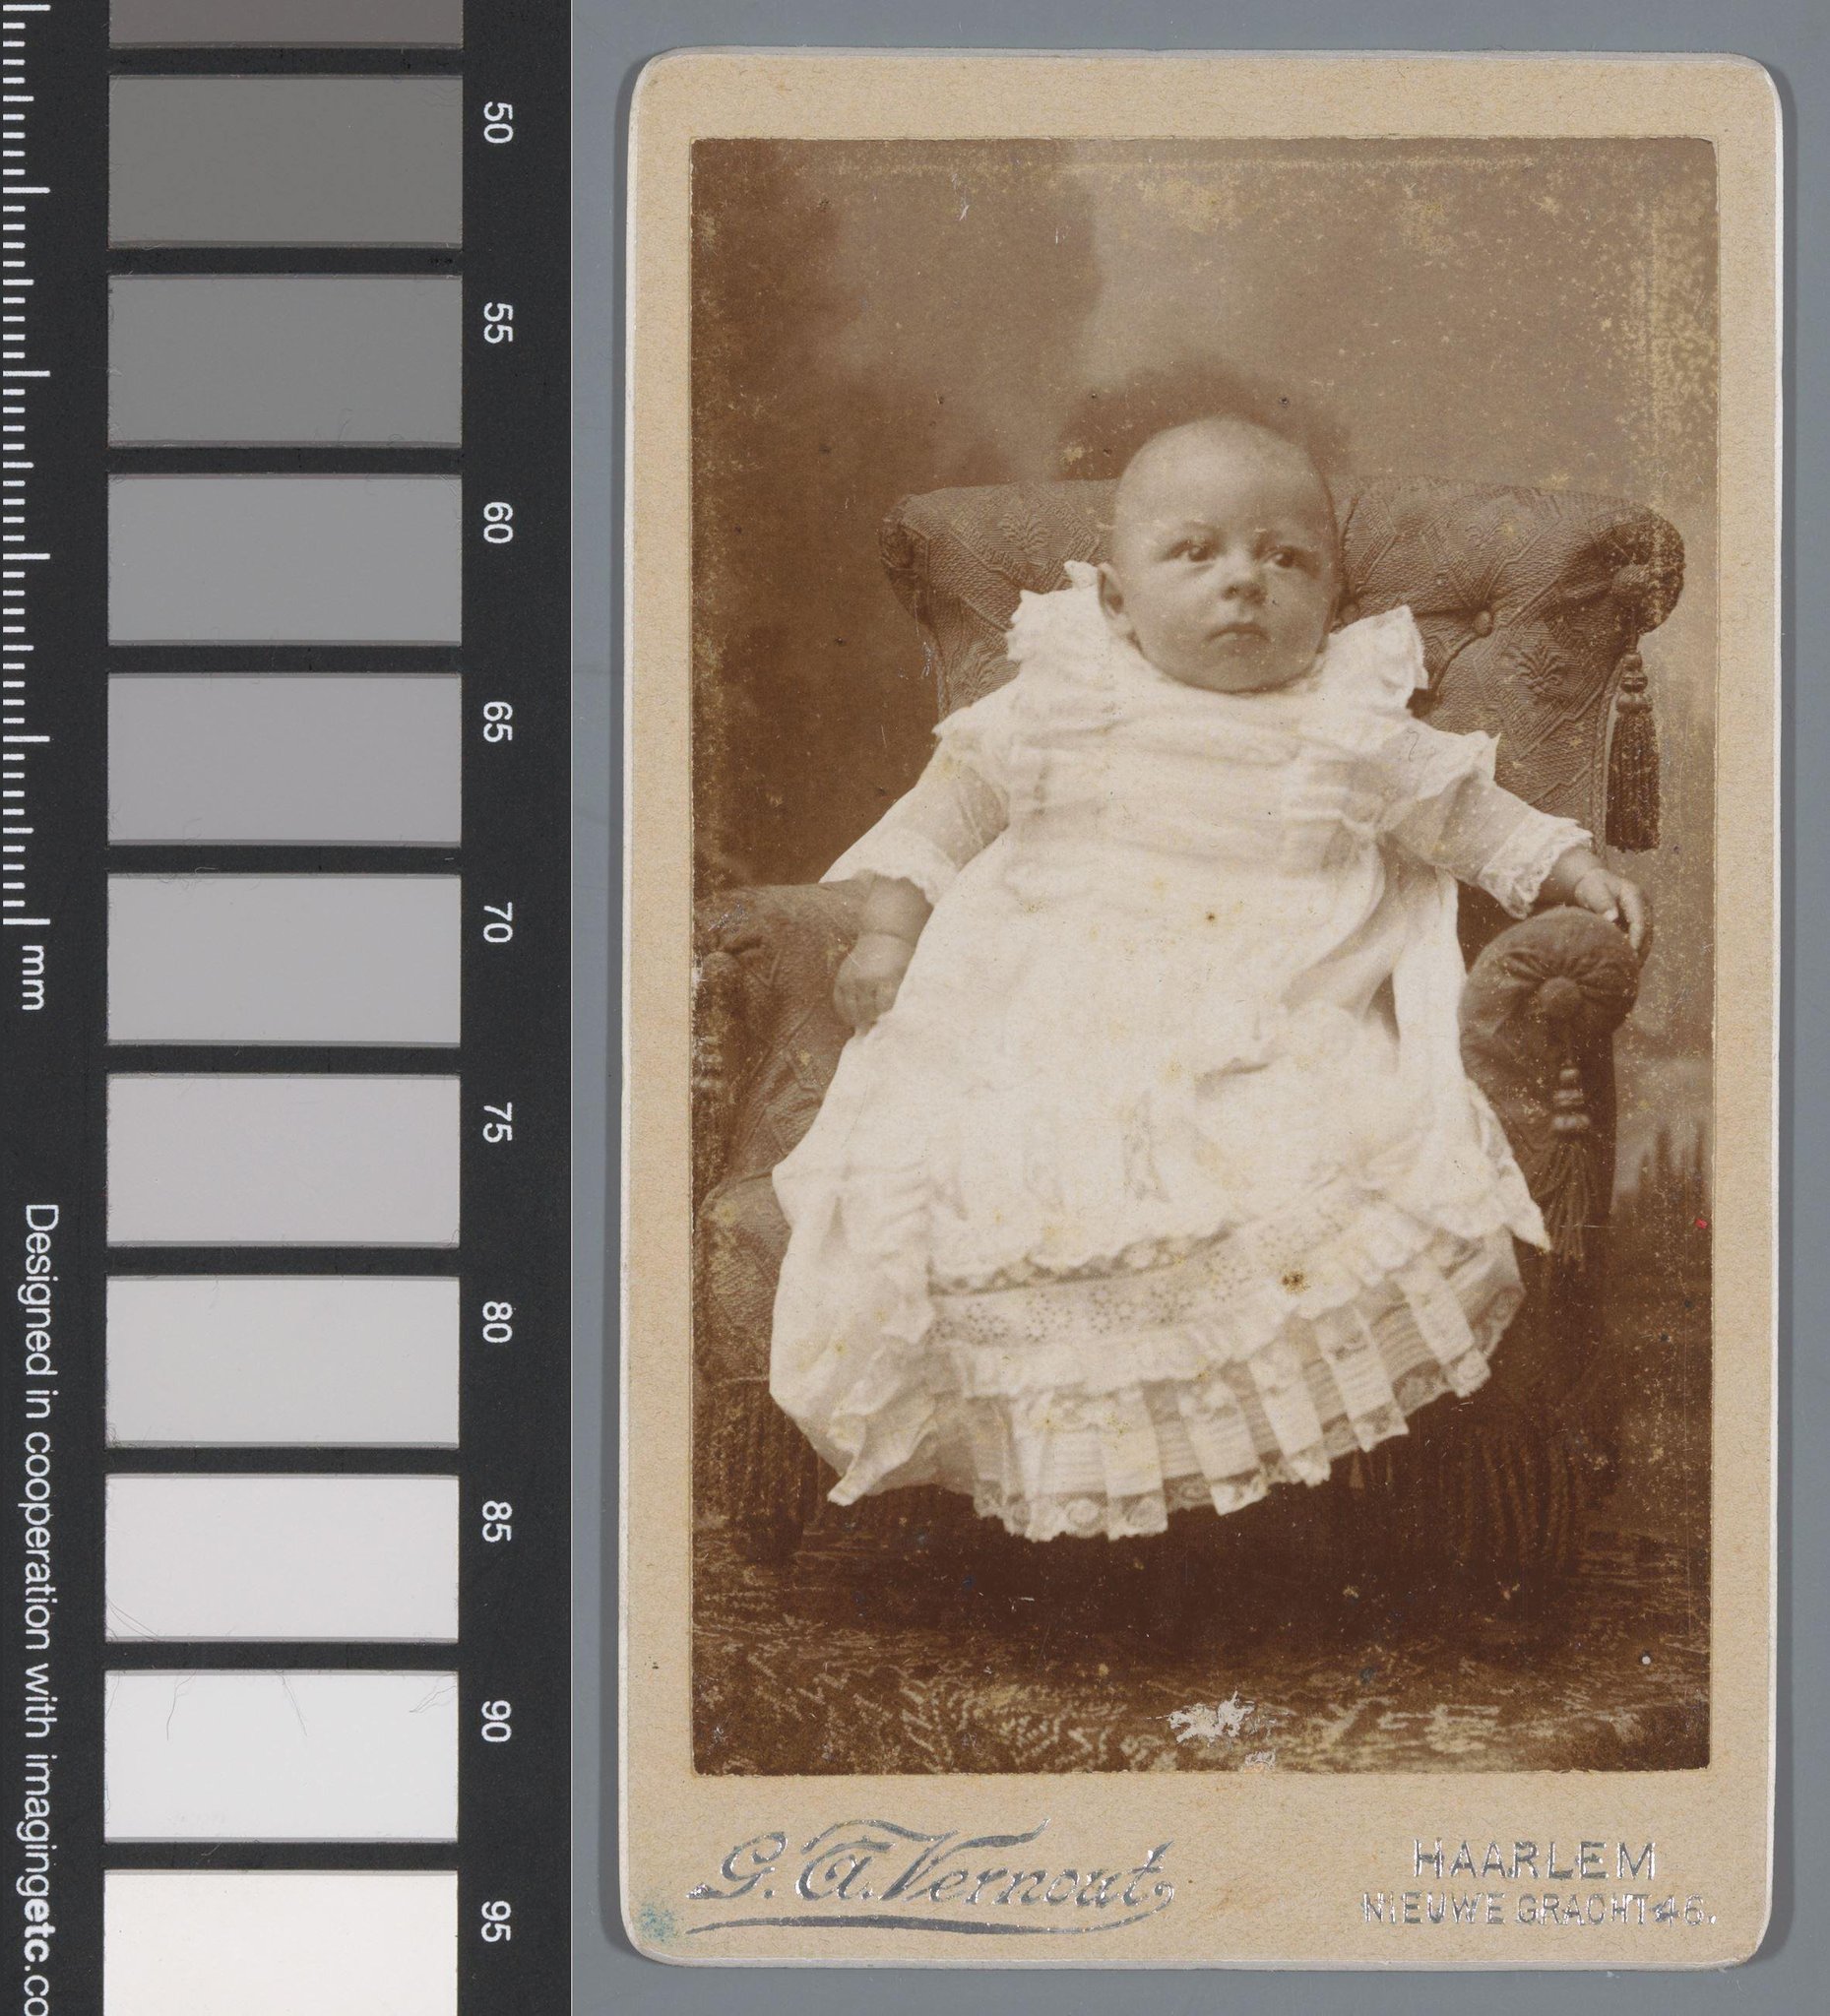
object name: carte de visite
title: Portret van een onbekende baby, aangeduid als Freddie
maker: g. a. vernout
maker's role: fotograaf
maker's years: 1848-1913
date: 1880-1913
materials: cardboard, photographic support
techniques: gelatin silver print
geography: haarlem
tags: historical persons, infant, baby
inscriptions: inscription: ‘4 maanden en/ tien dagen oud’, inscription: ‘Freddie vd Most v Spyk/ aan zijn neef P vd/ Waeyen Pieterszoon.’, address: ‘G. A. Vernout/ HAARLEM/ NIEUWE GRACHT 46’